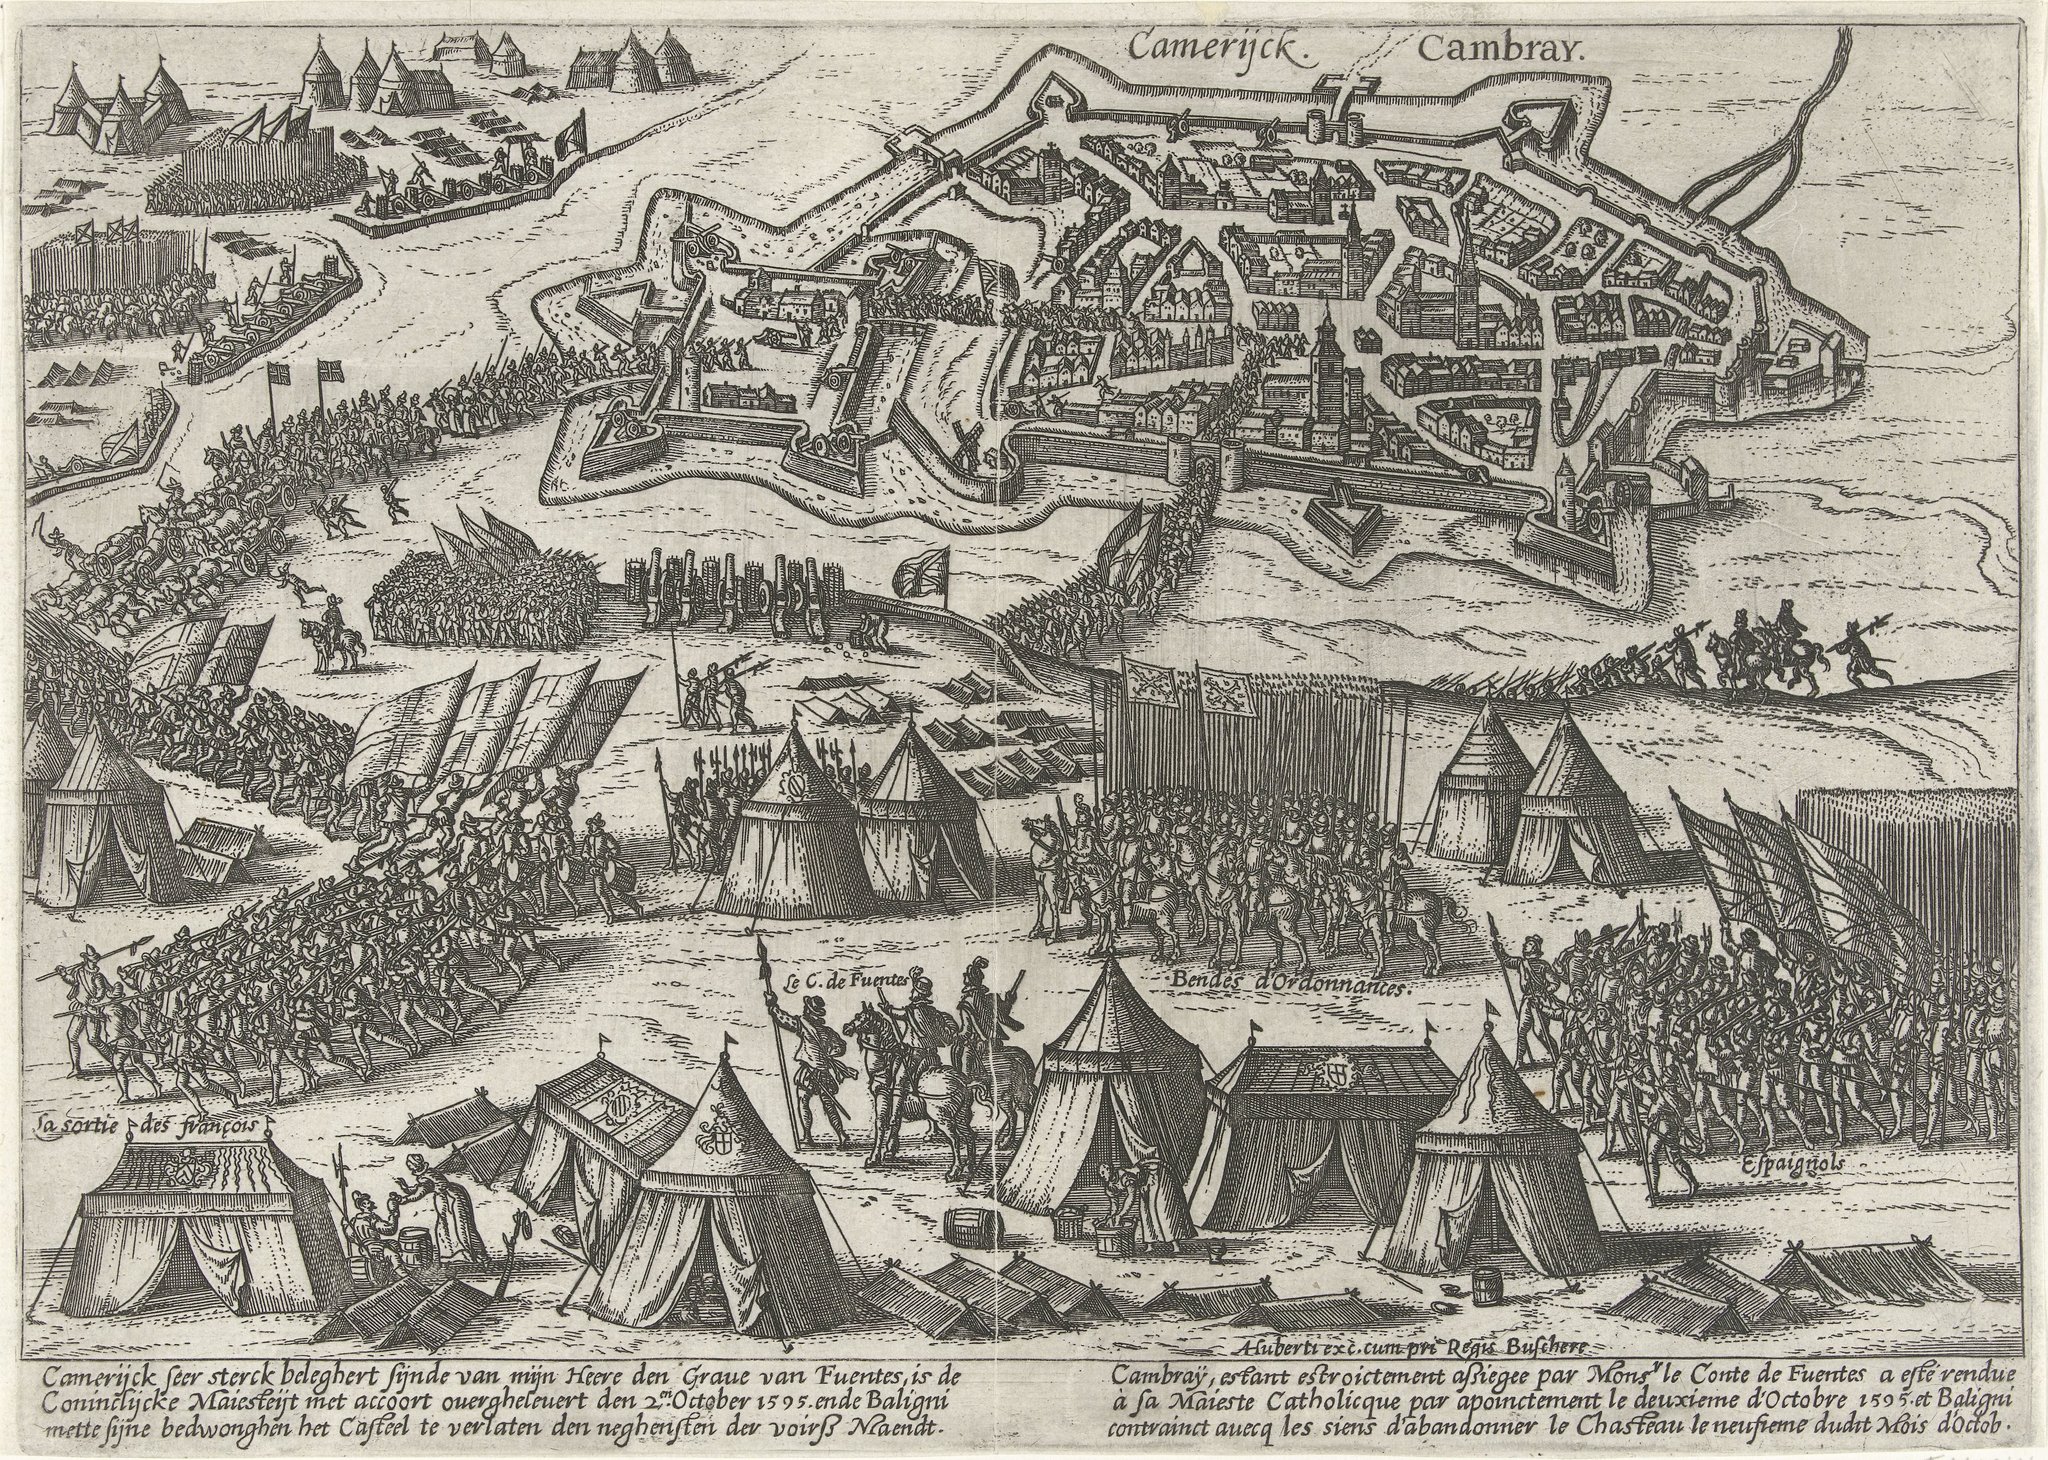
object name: print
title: Kamerijk belegerd en ingenomen door Fuentes, 1595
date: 1595-1597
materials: paper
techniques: etching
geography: southern netherlands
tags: politician, pedro enríquez de acevedo (count of fuentes), capture of city (after the siege)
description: Kamerijk belegerd en ingenomen door het Spaanse leger onder Fuentes, 2 oktober 1595. Op de voorgrond het Spaanse legerkamp waarin Fuentes toeziet hoe de Fransen wegtrekken uit de stad. Met onderschrift van 3 regels in het Nederlands en 3 regels in het Frans.